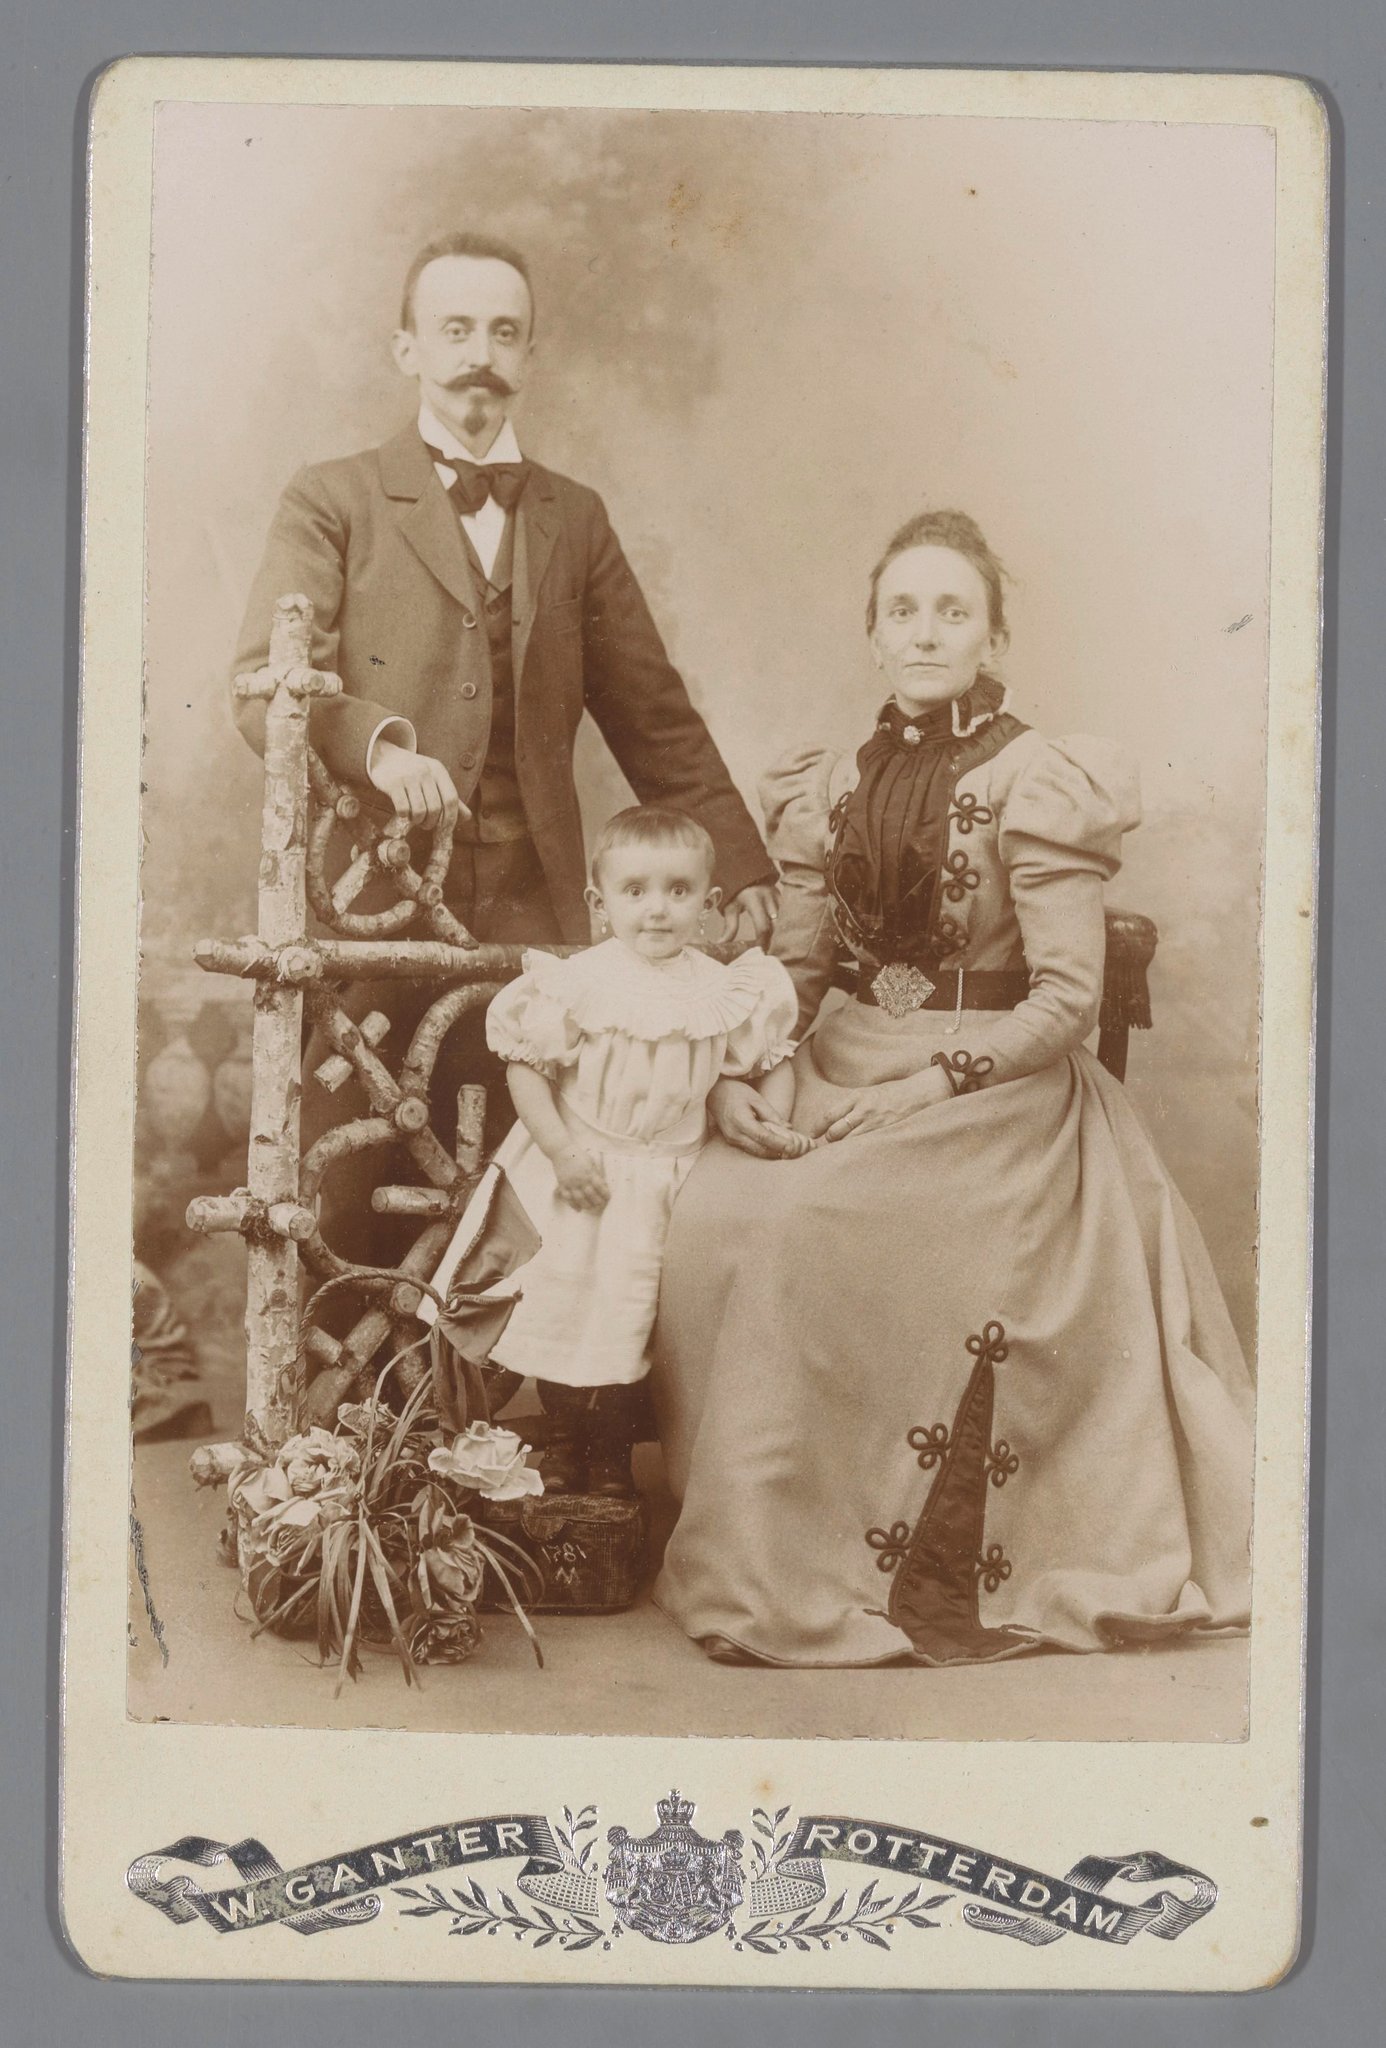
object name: cabinet photograph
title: Portret van een onbekende man, vrouw en kind, vermoedelijk een gezin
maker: willem ganter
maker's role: fotograaf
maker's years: 1849-1908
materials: cardboard, photographic support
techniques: collodion silver print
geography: rotterdam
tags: studio requisites ~ photographer, family group, especially parents with their child(ren)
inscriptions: name: ‘Wm Ganter Hofleverancier Broeder van het roode kruis van Belgie. Photographie Artistique Rotterdam Jonker Fransstraat 120.’